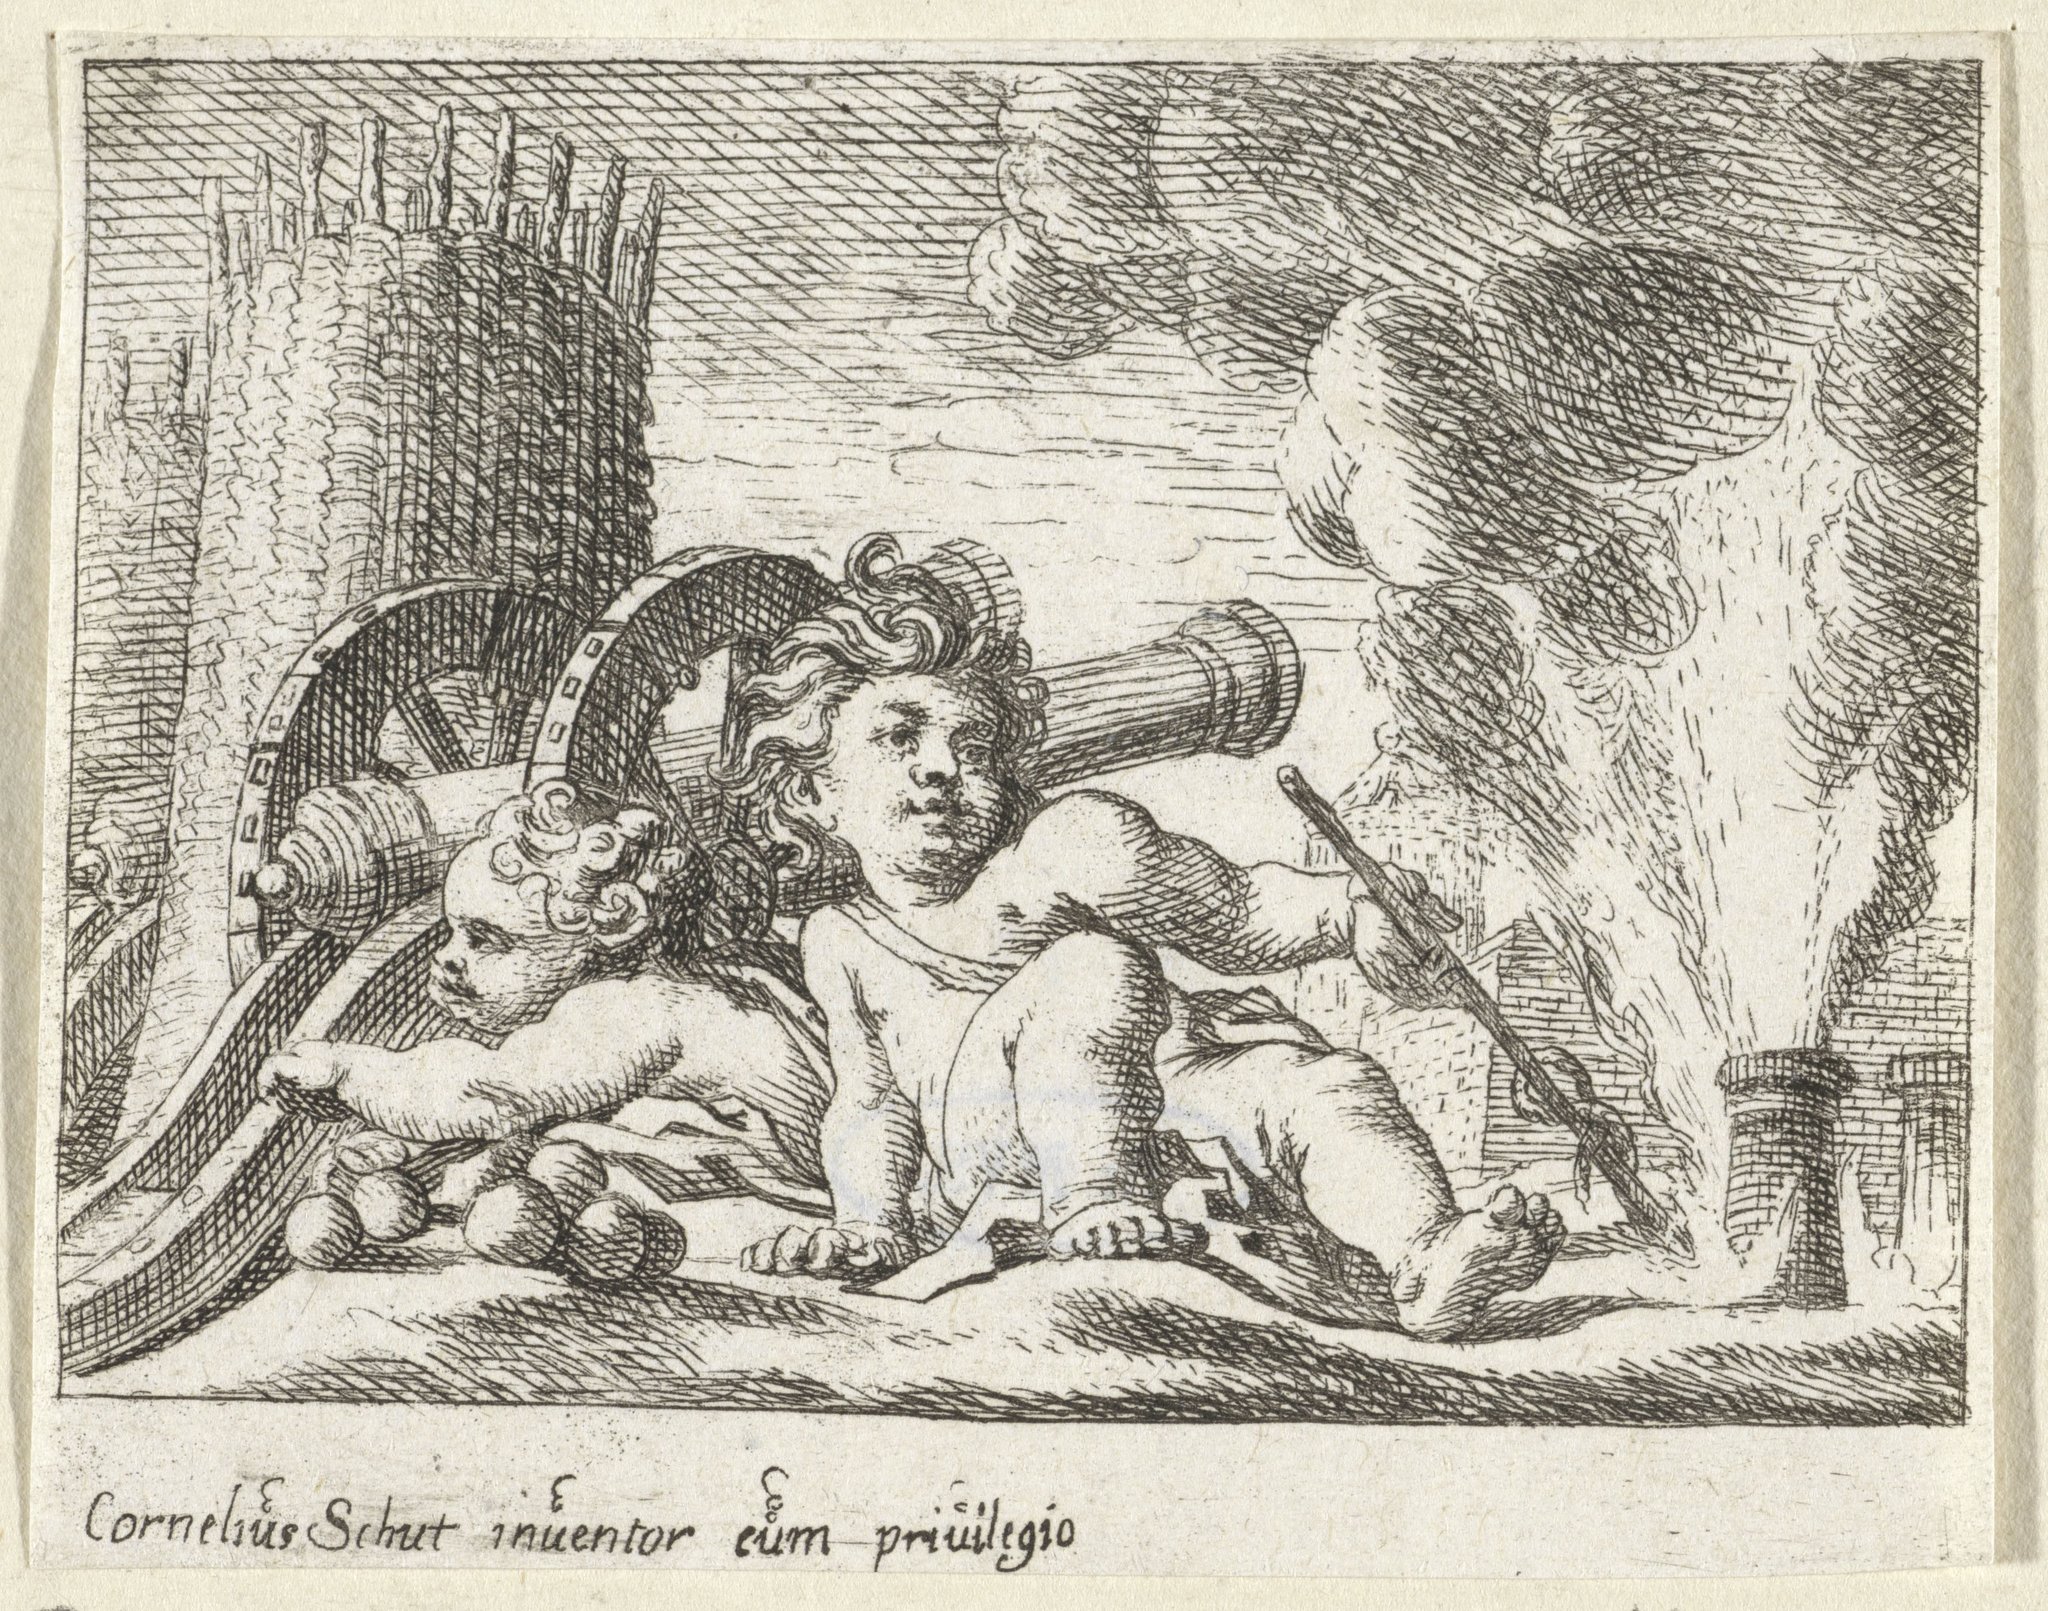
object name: print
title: Twee kinderen met kanonnen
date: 1618-1655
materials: paper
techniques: engraving, etching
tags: child, firearms, temporary fortifications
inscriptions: collector's mark: Lugt 2228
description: Een kind vuurt loodrecht in de grond geplaatste kanonnen af. Het heeft een lont in de hand. Een ander kind zit bij een kanon naast een schanskorf.